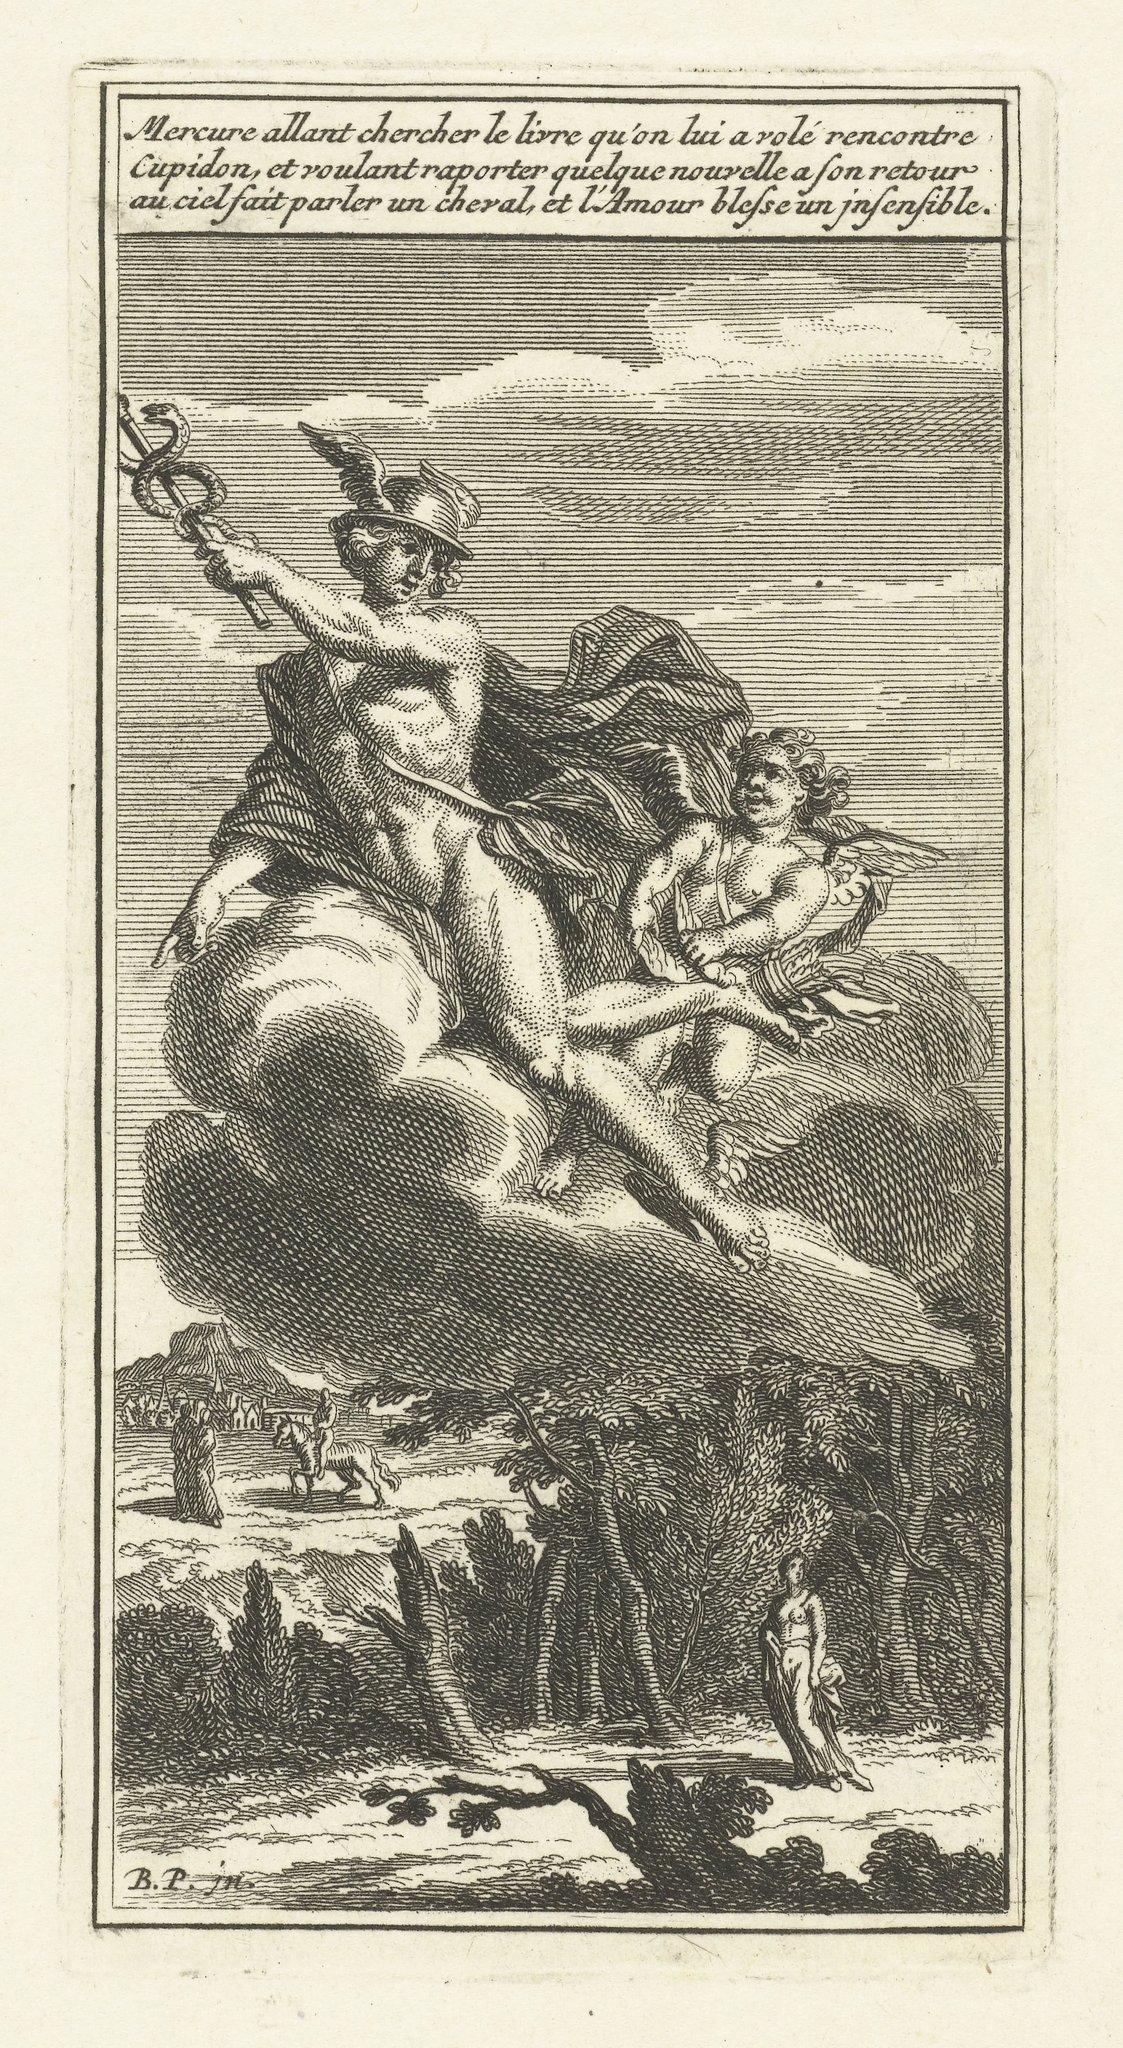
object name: print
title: Mercurius en Cupido op een wolk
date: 1700-1750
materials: paper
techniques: etching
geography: amsterdam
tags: (story of) mercury (hermes), (story of) cupid, amor (eros)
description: Illustratie voor: Bonaventure Des Perriers, Jean. Cymbalum mundi, ou Dialogues satyriques sur differens sujets. Amsterdam P. Marchand, 1711. Ook in latere edities van hetzelfde werk gebruikt.